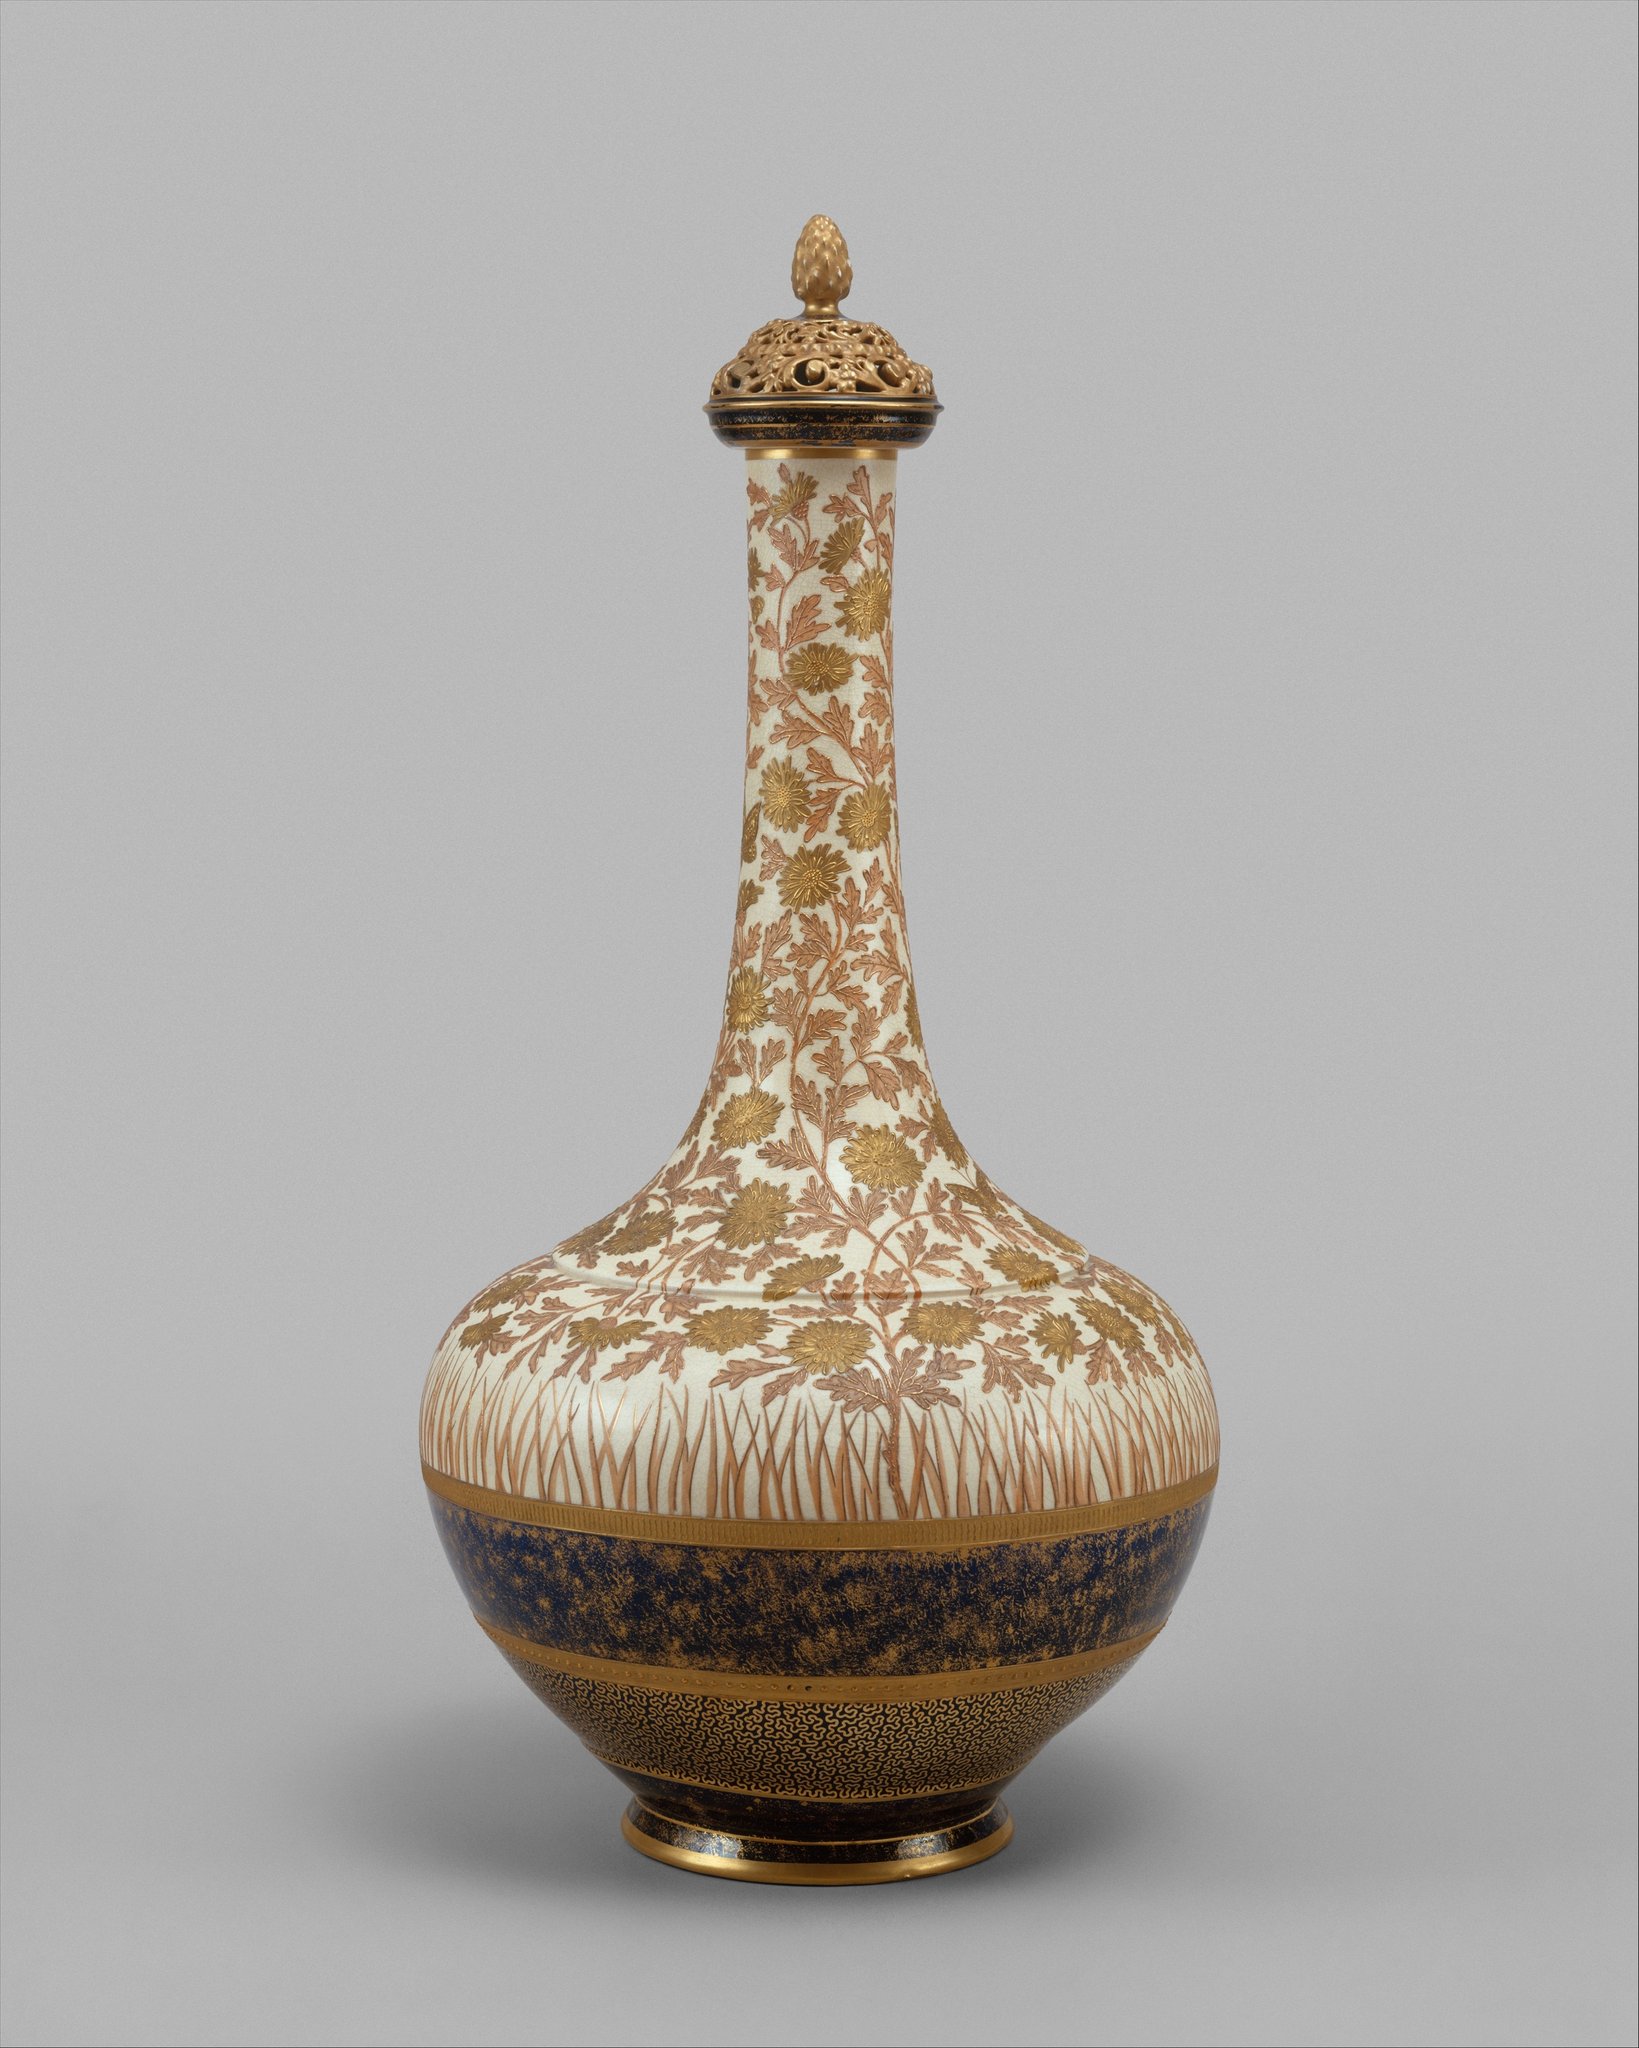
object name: vase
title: Covered Vase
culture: american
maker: edward lycett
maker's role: designer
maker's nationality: american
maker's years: 1833-1910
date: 1886-1890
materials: earthenware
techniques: gilding, glazing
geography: united states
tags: flowers